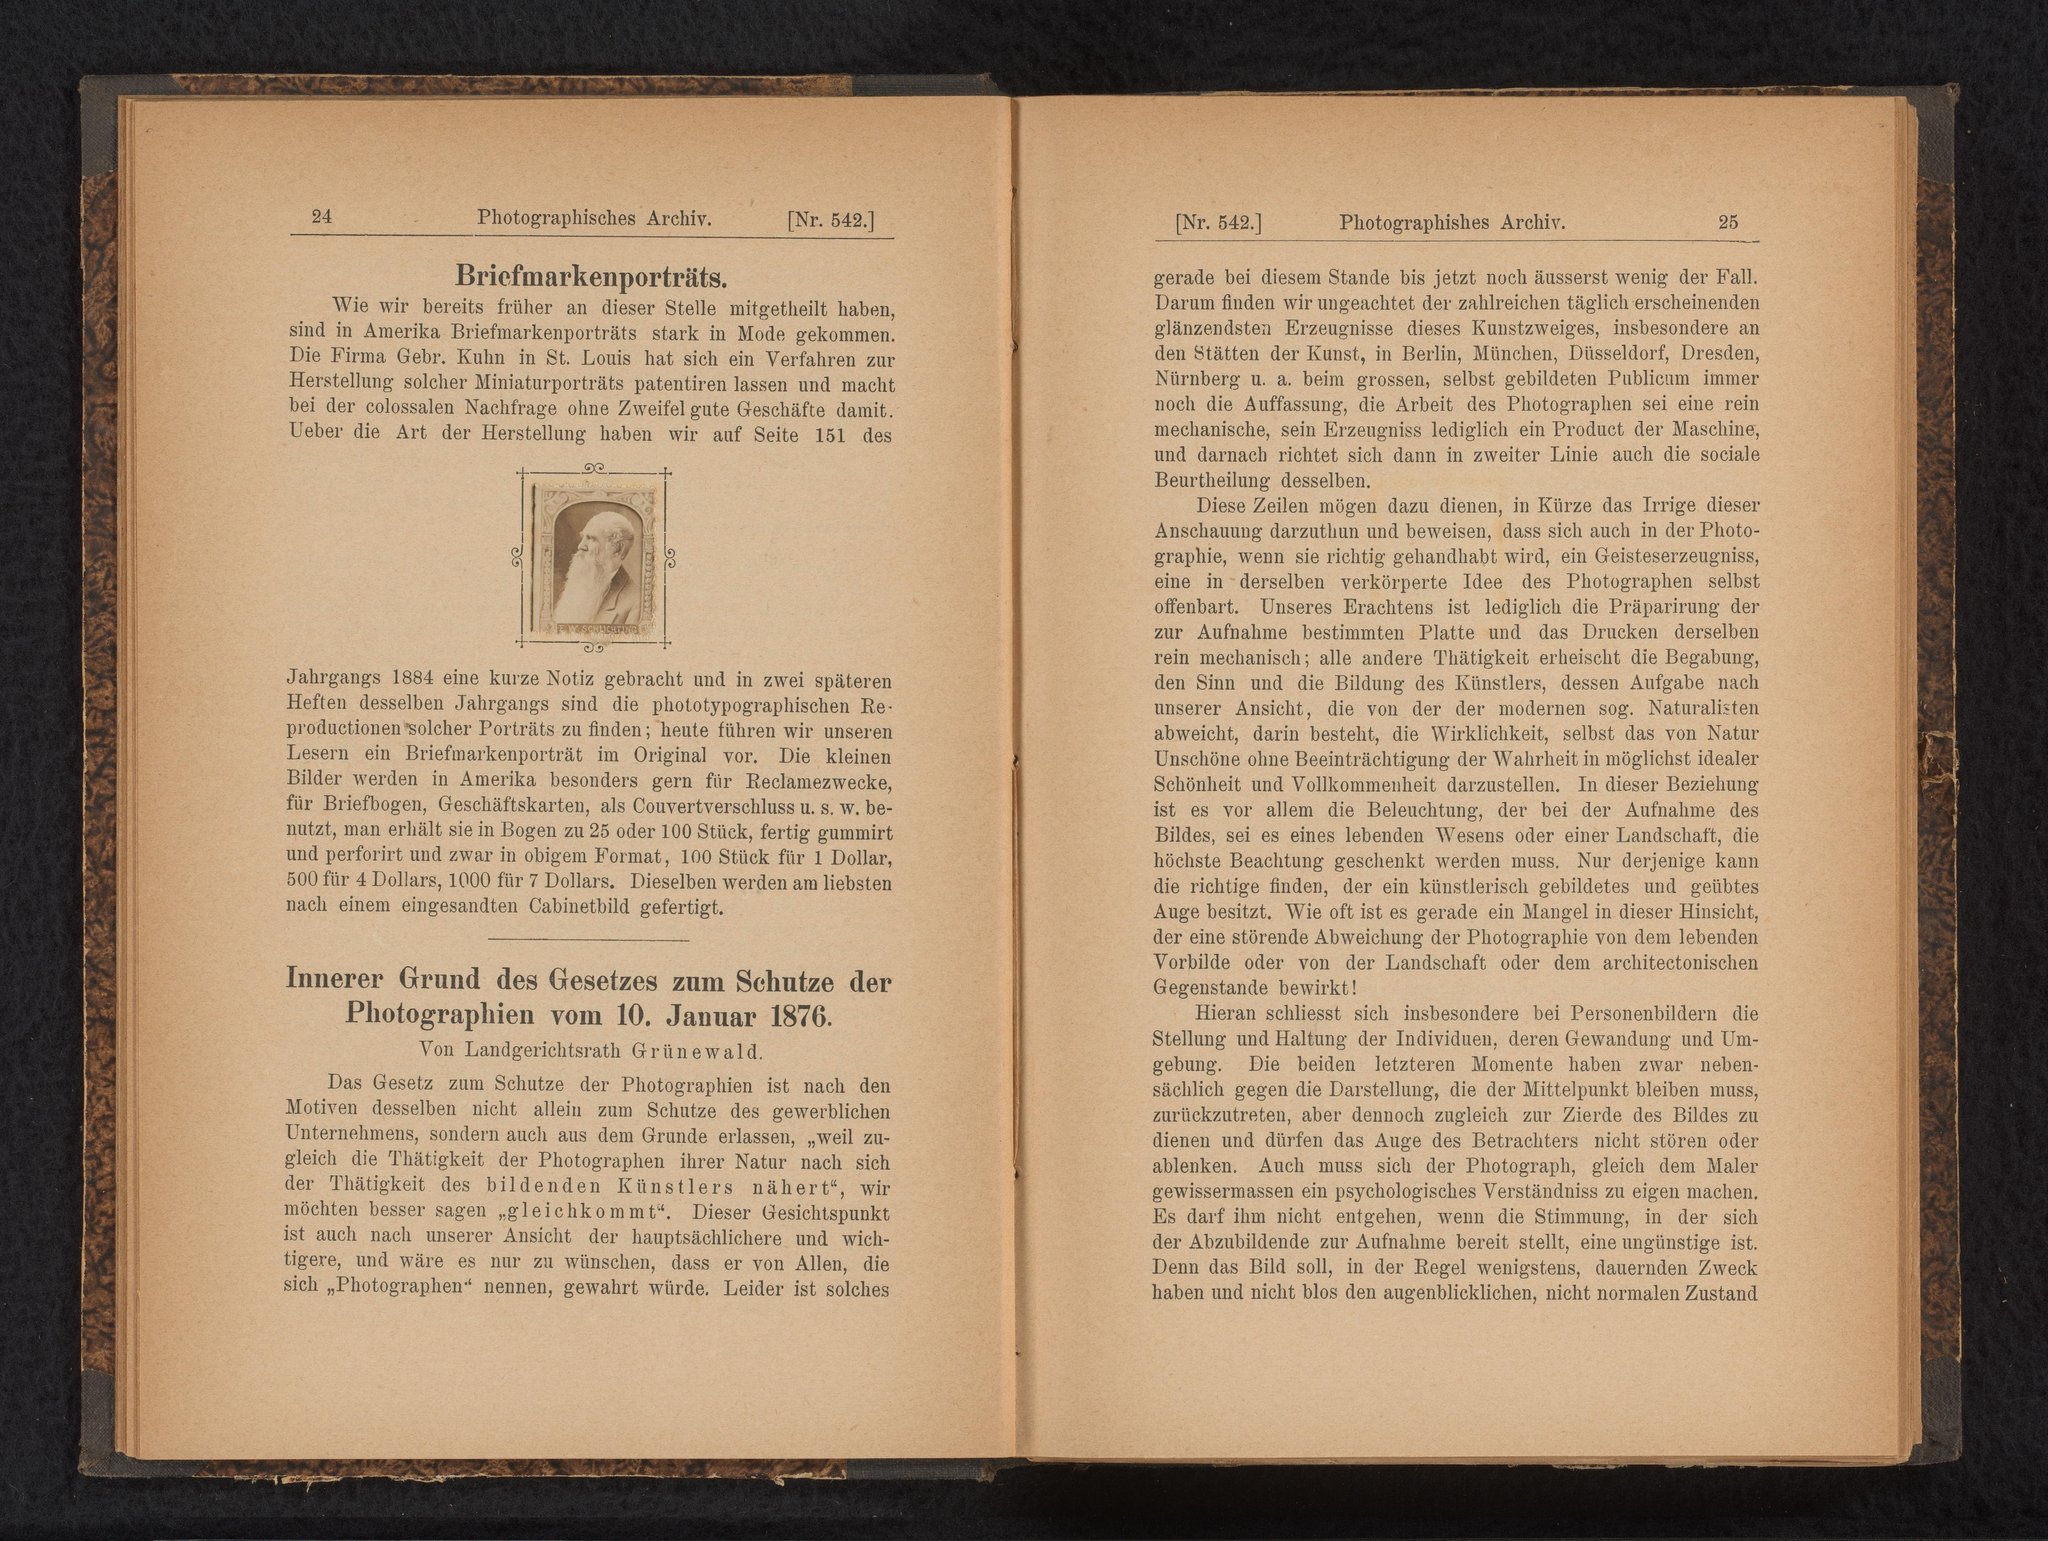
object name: page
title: Portret van E.W. Schlichting,uitgevoerd als postzegel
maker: Anonymous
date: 1881-1886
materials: paper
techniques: albumen print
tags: historical persons